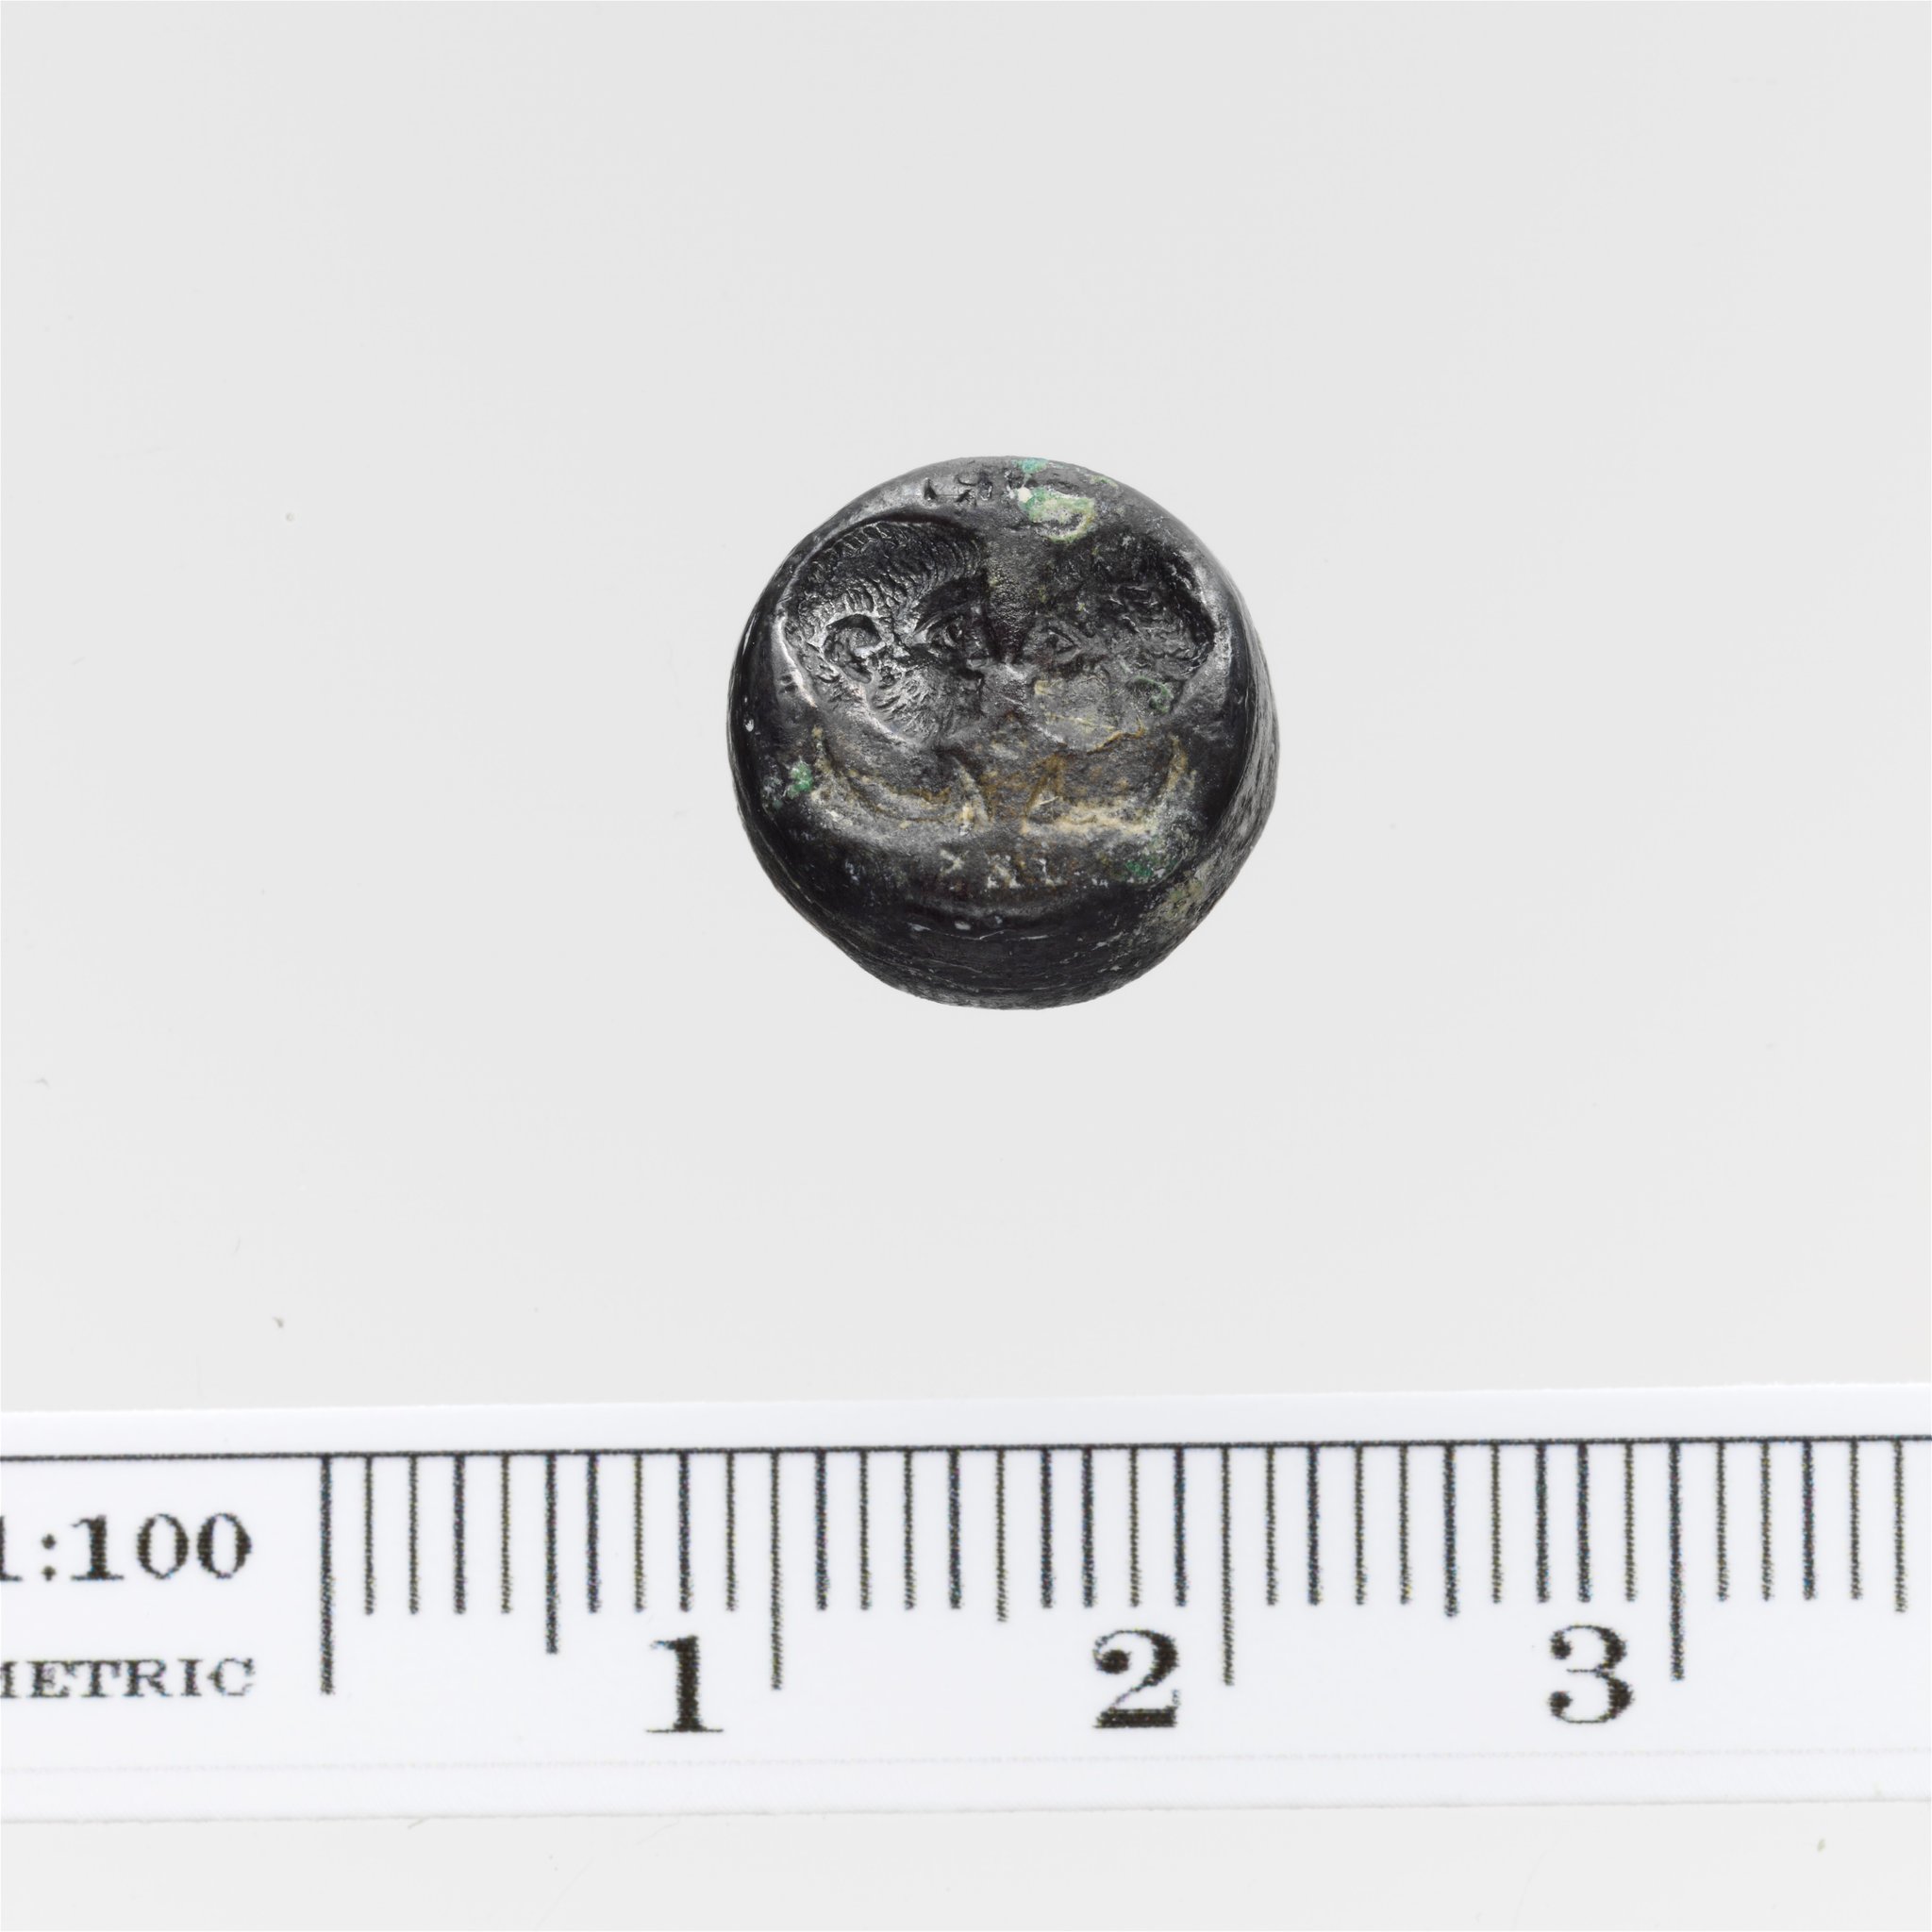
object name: intaglio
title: Silver ring stone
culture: roman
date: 301-350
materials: silver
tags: men,profiles,women